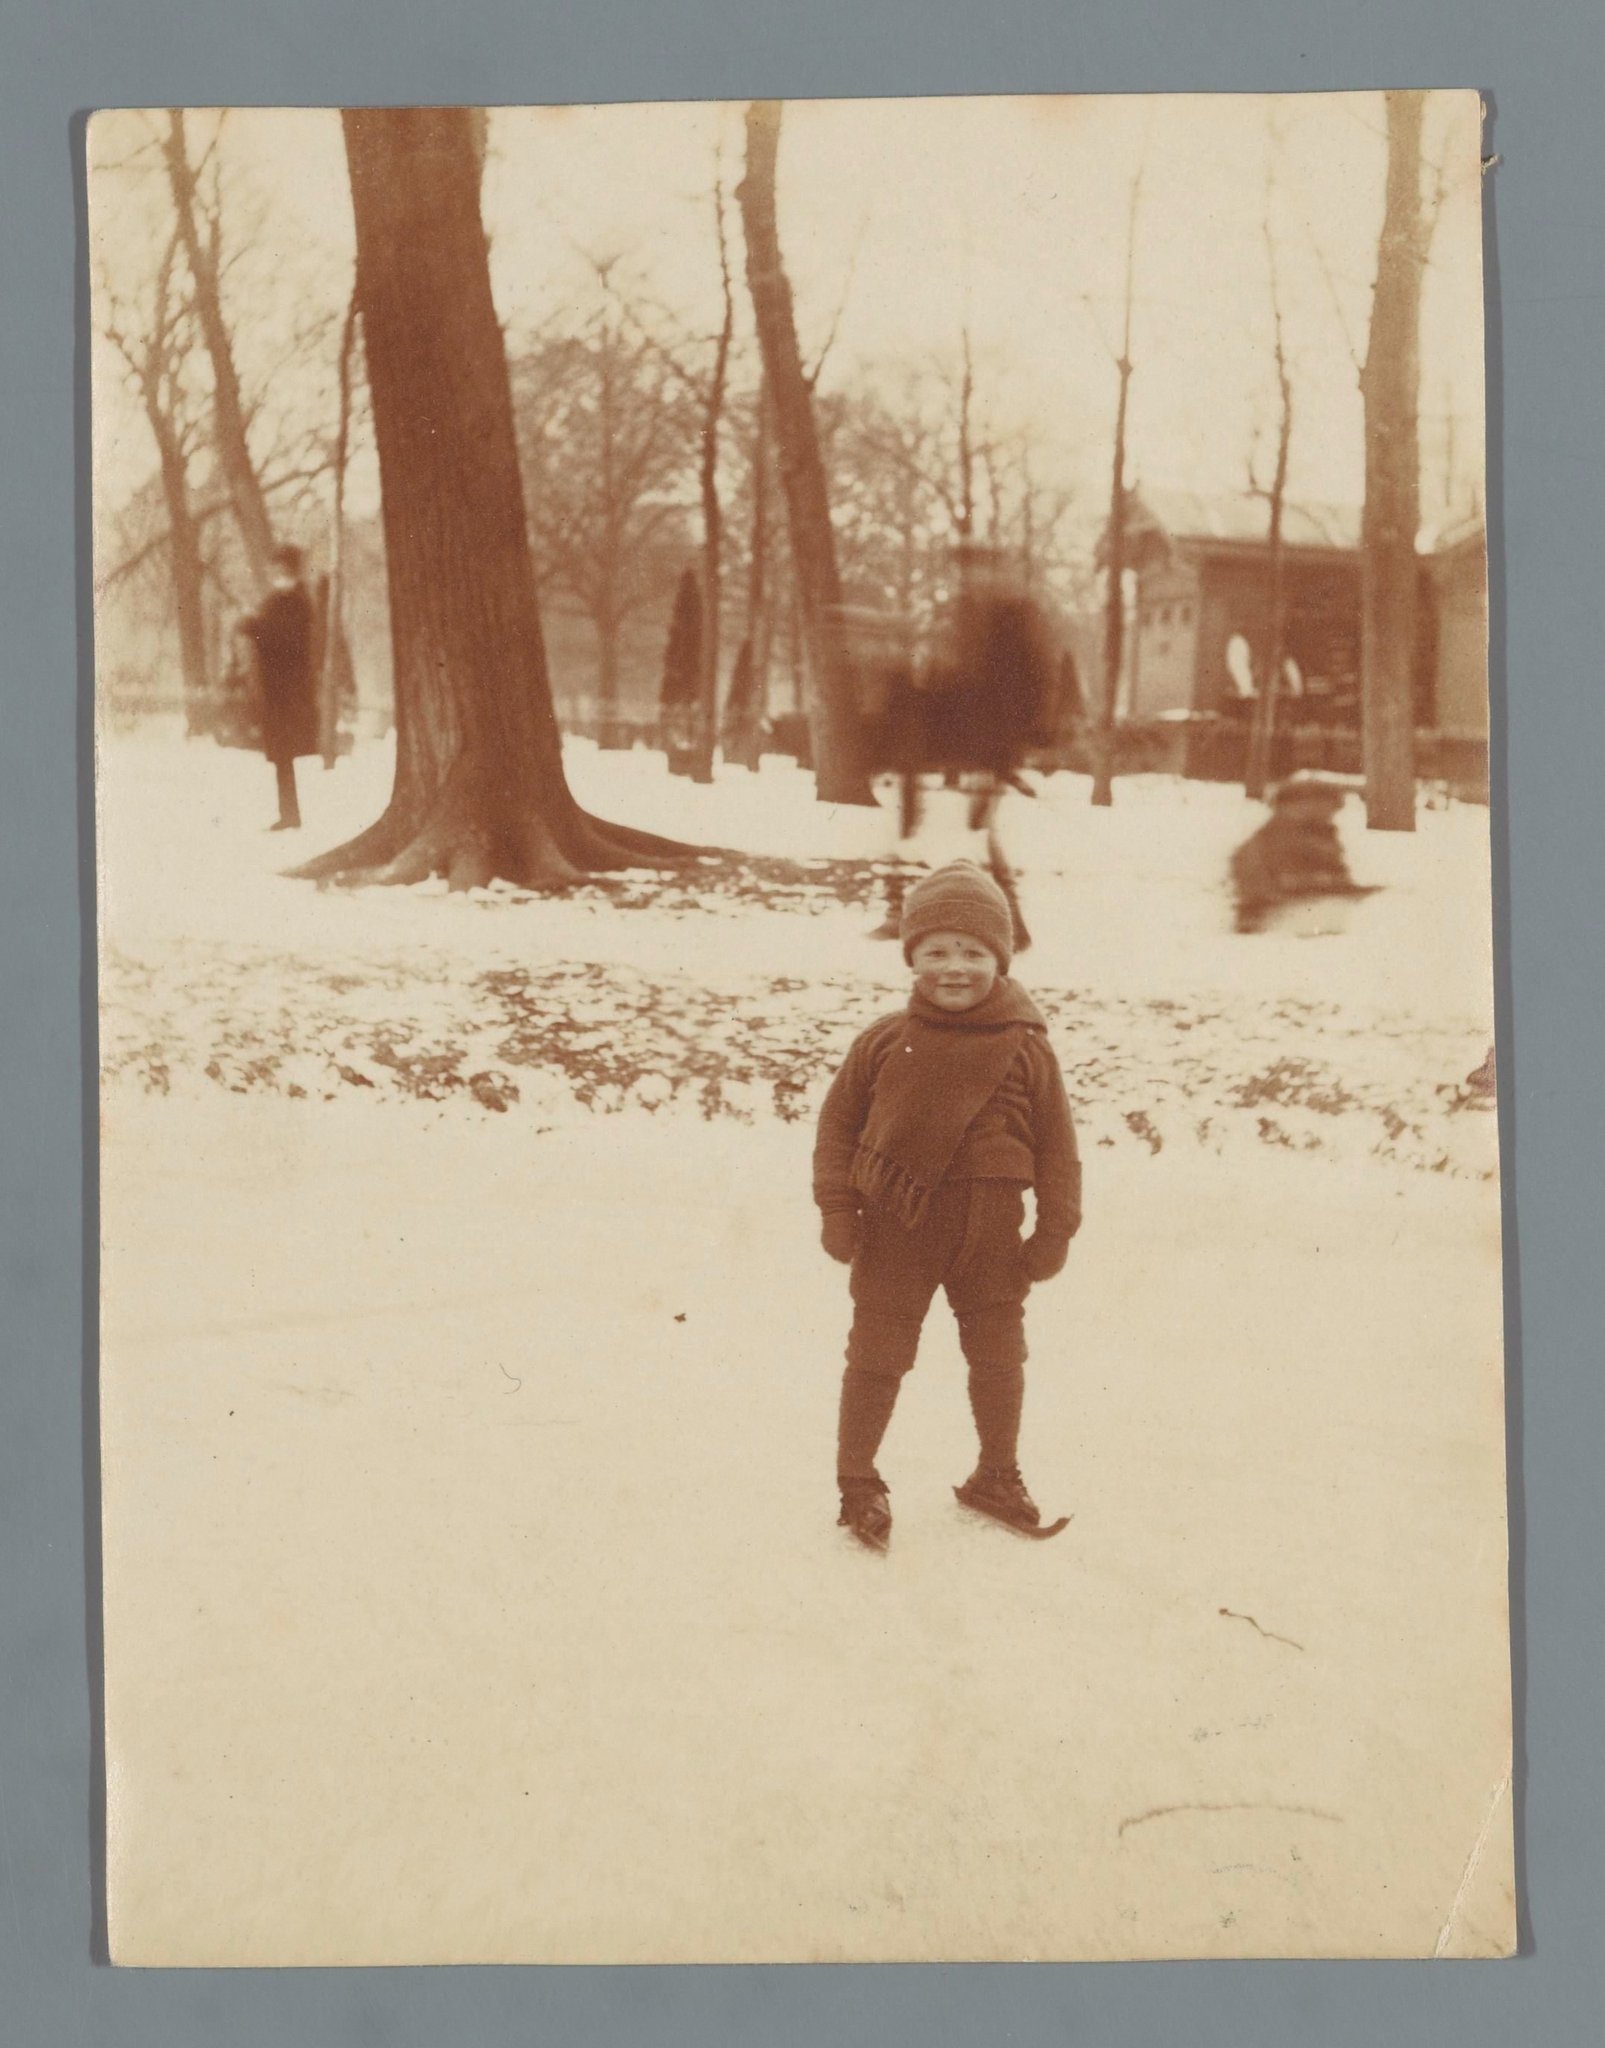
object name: photograph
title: Portret van een onbekend kind op schaatsen op een bevroren vijver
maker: Anonymous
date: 1900-1920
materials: photographic support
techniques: gelatin silver print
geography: netherlands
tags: child, skates (winter sports), pond, pool